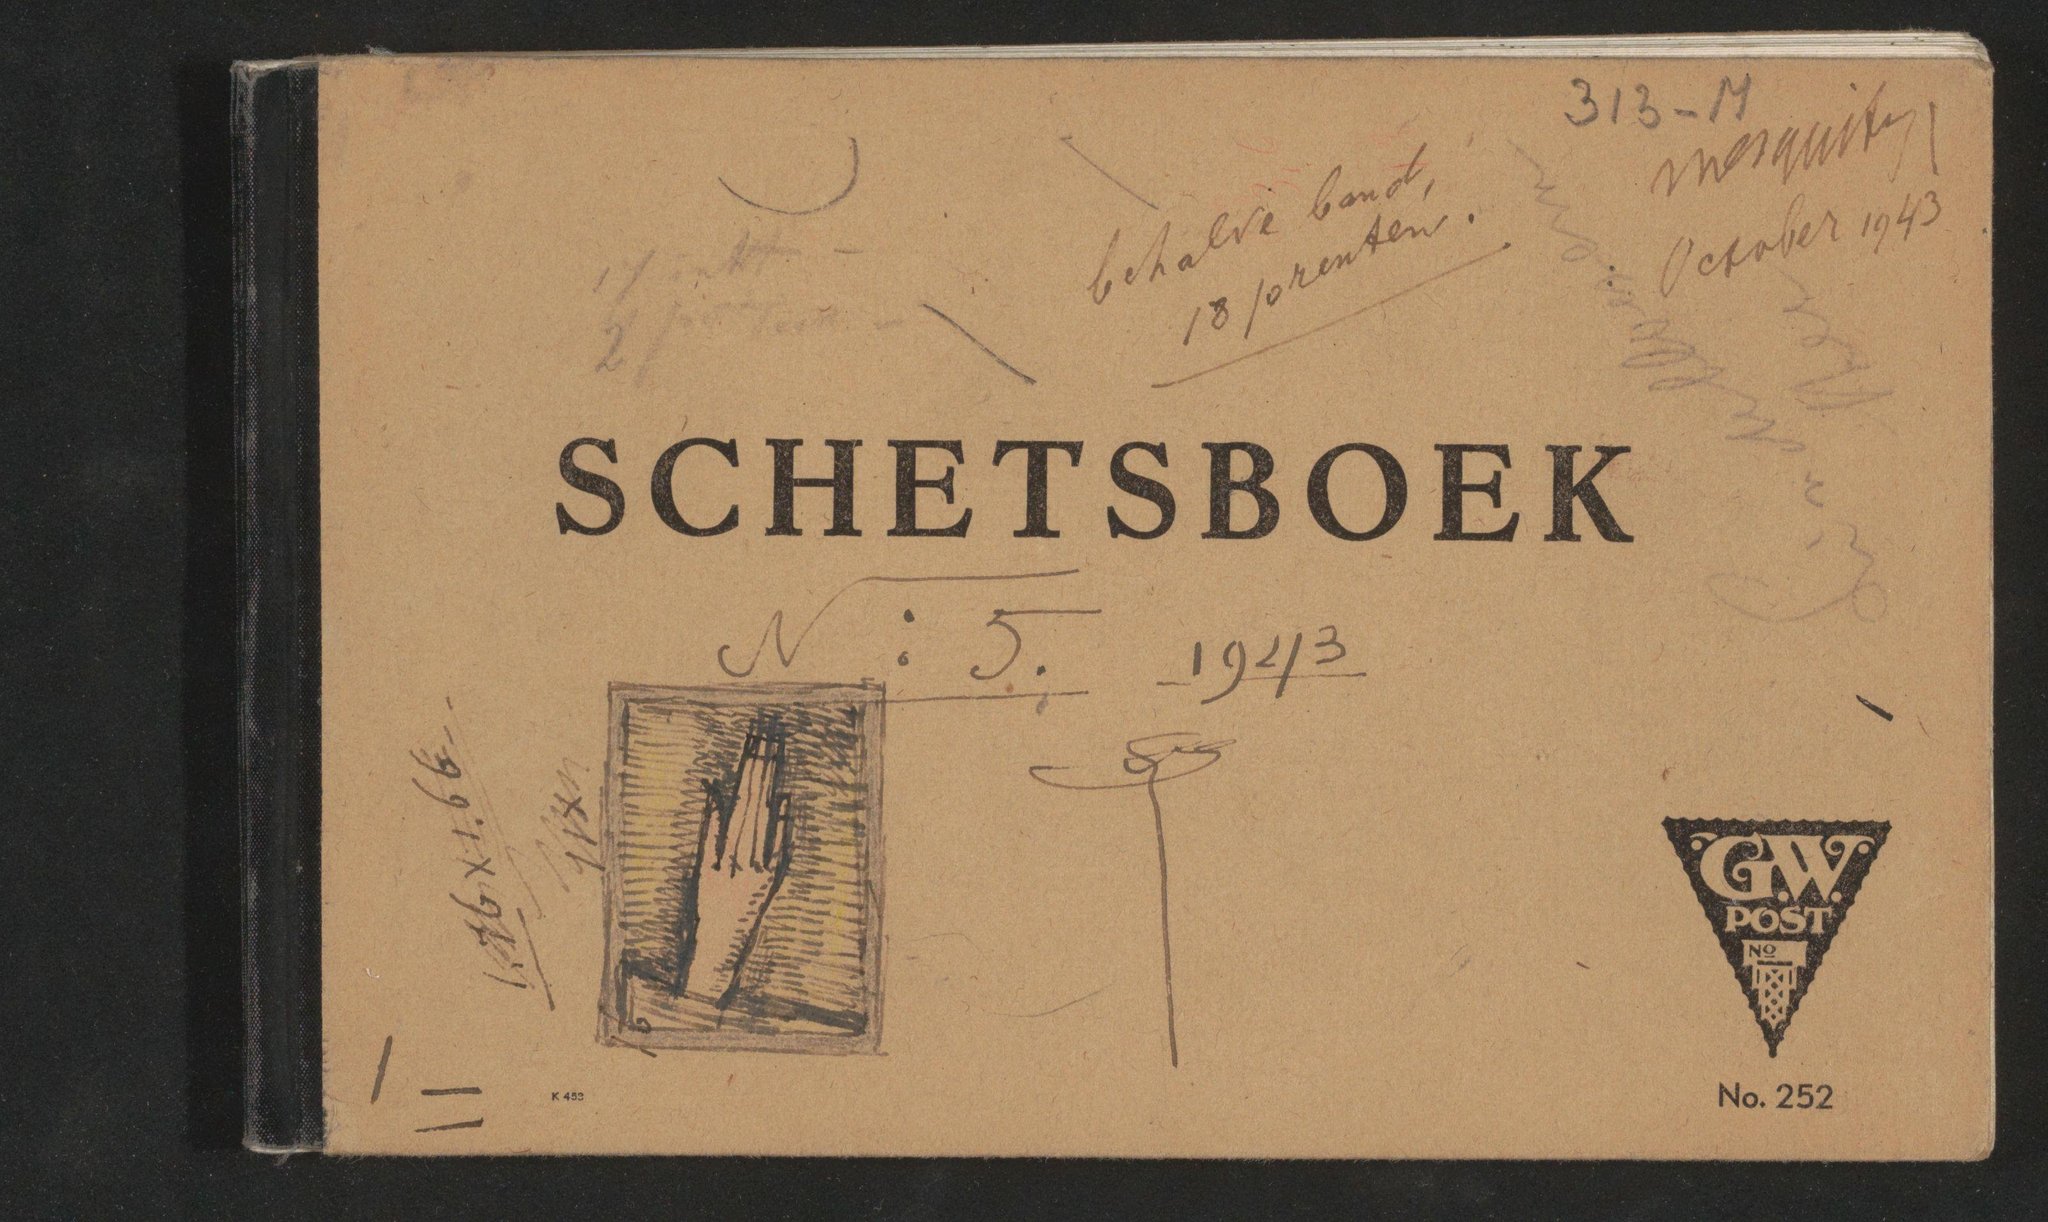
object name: sketchbook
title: Schetsboek met 18 bladen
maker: samuel jessurun de mesquita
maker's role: draughtsman, print maker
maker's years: 1868-1944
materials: cardboard, ink, linen, paper, pencil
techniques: pen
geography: amsterdam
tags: adult woman, animals, adult man, anthropomorphic beings (legendary or not) with heads, limbs or organs of an abnormal number, in abnormal places or of an abnormal shape)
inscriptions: retailer's mark: ‘SCHETSBOEK/ G.W./ POST/ No./ No. 252’, annotation: ‘1.76 x 1.66./ 11x/ N: 5 1943/ behalve band,/ 18 prenten/ 313-14/ Lindebloesem/ thee’, collector's mark: Lugt 2228a, date and inscription: ‘Mesquita/ October 1943’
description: Schetsboek bestaande uit 18 bladen met (fantasie)figuren en dieren. Op de voorzijde van de boekband een schets van een opgeheven hand in pen en kleurpotlood.